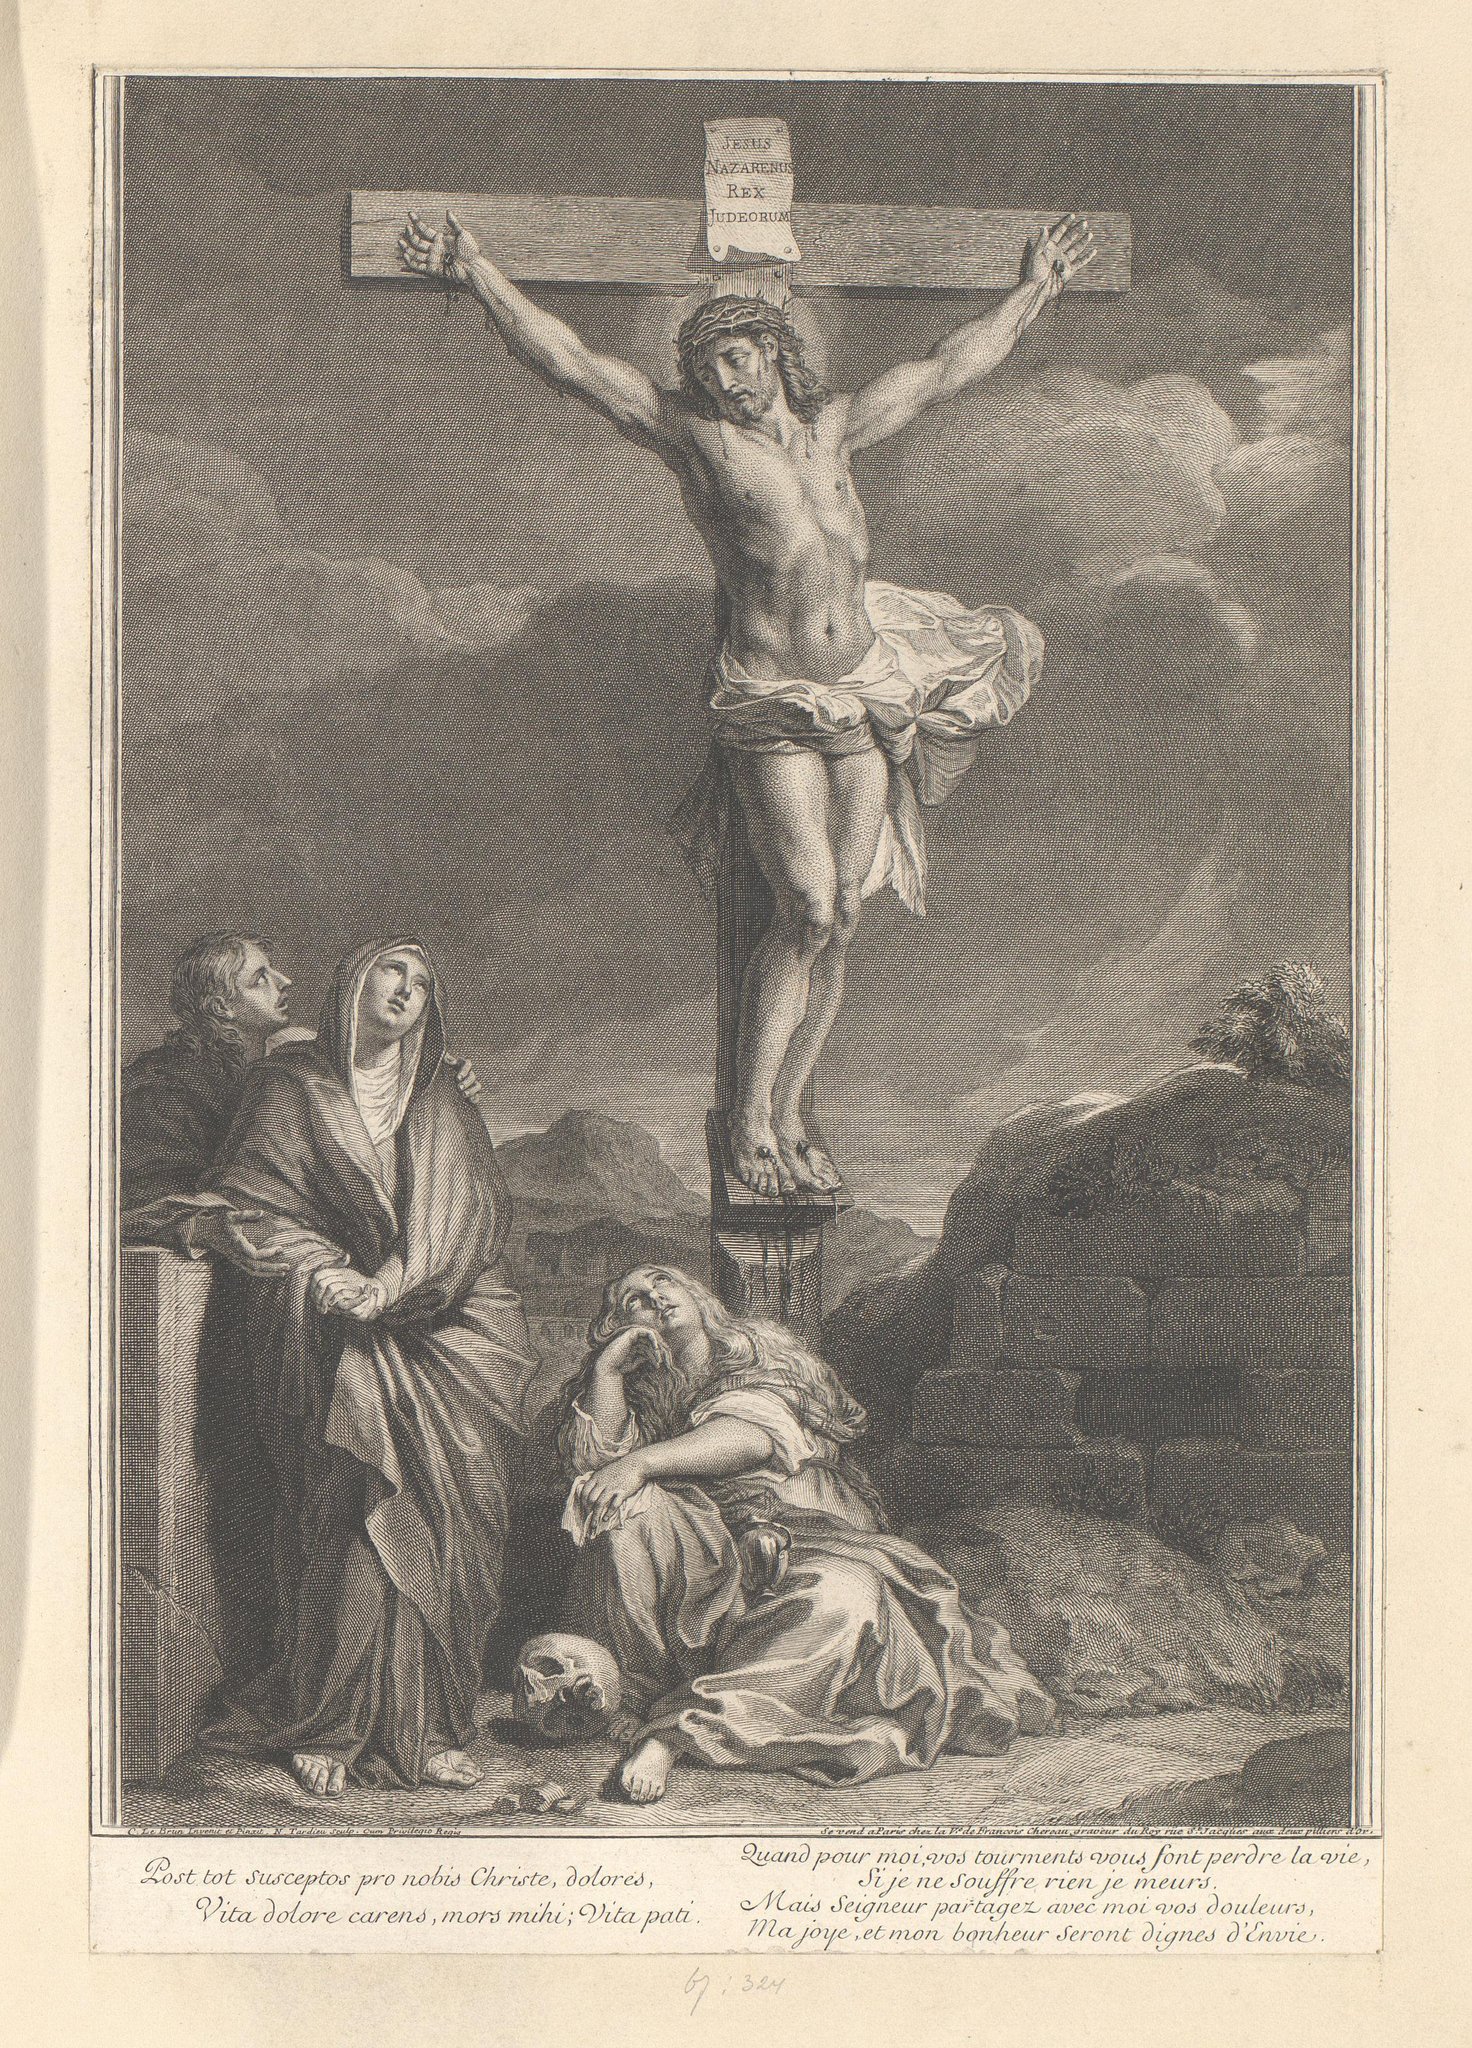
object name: print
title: Kruisiging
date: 1684-1749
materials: paper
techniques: engraving, etching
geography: paris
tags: crucified christ with mary, john, and mary magdalene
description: Met Maria Magdalena onderaan het kruis, en links Johannes en Maria. Deze prent maakt deel uit van een album.